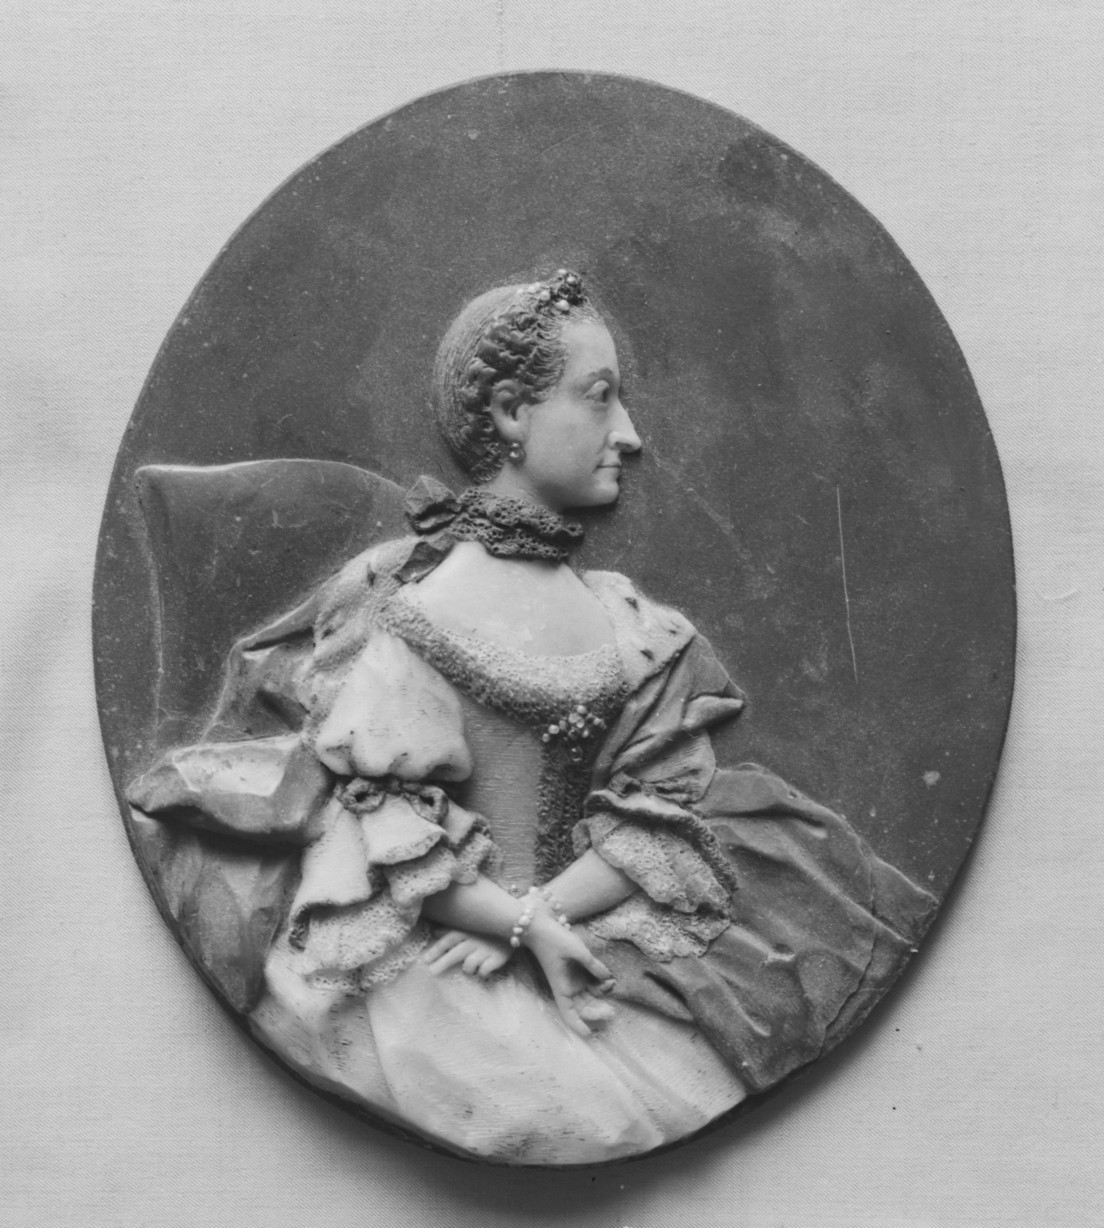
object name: relief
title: Portrait of a seated lady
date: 1767-1800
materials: wax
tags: profiles,women